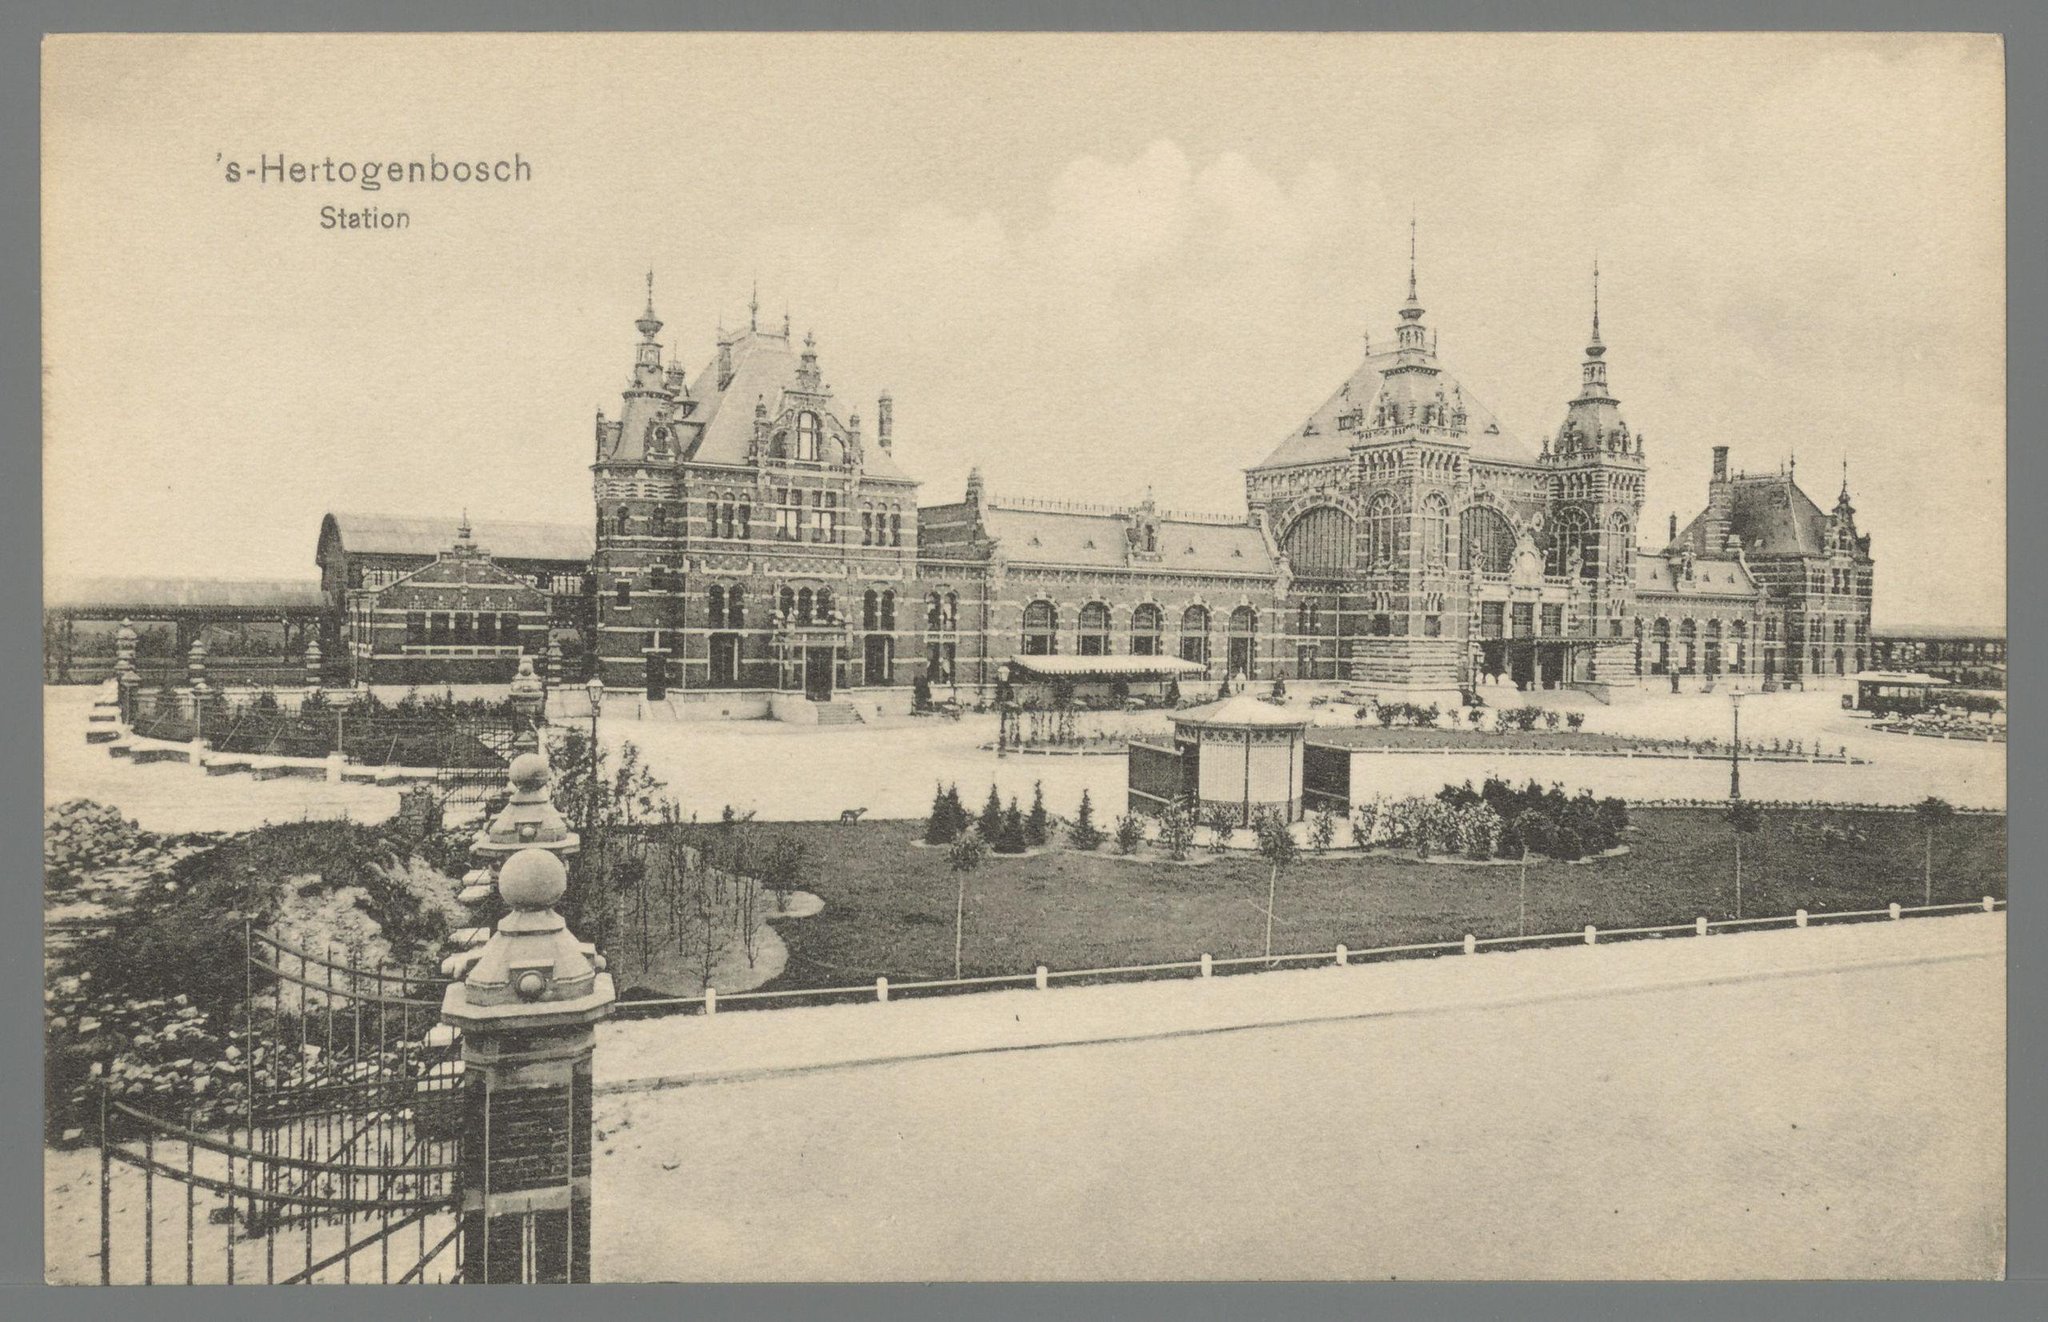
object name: photomechanical print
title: 's-Hertogenbosch. Station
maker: Anonymous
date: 1910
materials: cardboard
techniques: photograph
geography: den bosch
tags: station; shelter (railway, tramway), den bosch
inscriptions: date